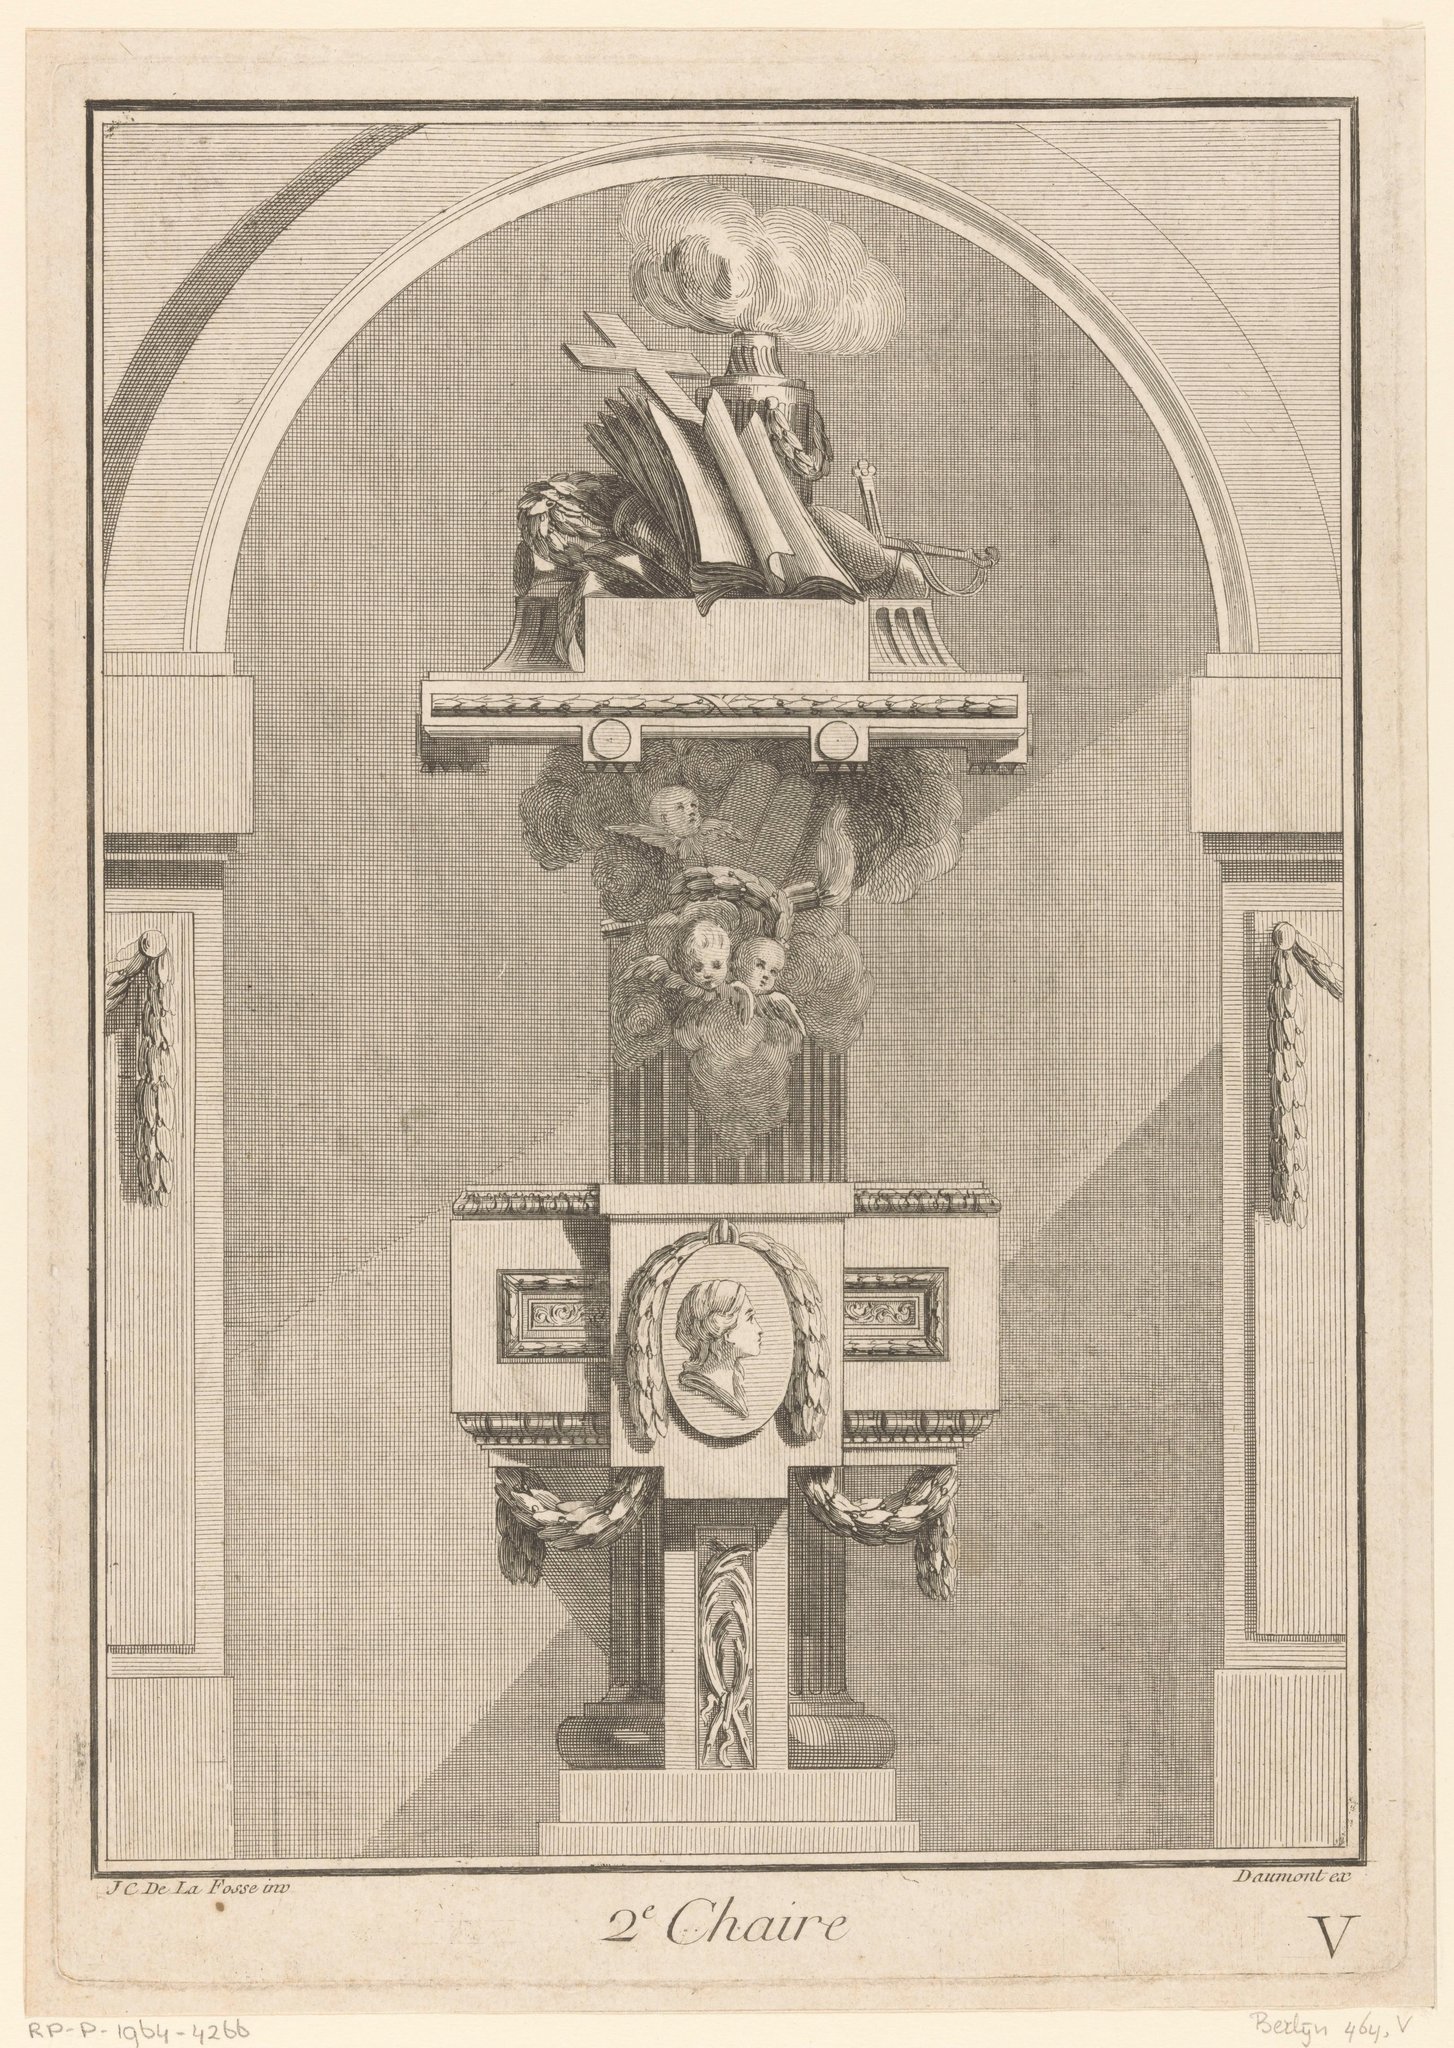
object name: ornament print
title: 2e Chaire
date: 1745-1755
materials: paper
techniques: engraving, etching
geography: paris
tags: pulpit, ambo, chancel, incense-burner ~ scents, perfumes, cupids: 'amores', 'amoretti', 'putti'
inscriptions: collector's mark: Lugt 2228, collector's mark: Lugt 2760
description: Een preekstoel met guirlandes, een medaillon met vrouwenportret en profil, daarboven puttohoofden met lauwerkrans en fakkel in wolken. Op de bekroning een rookvat, kruis, boek en een krans.